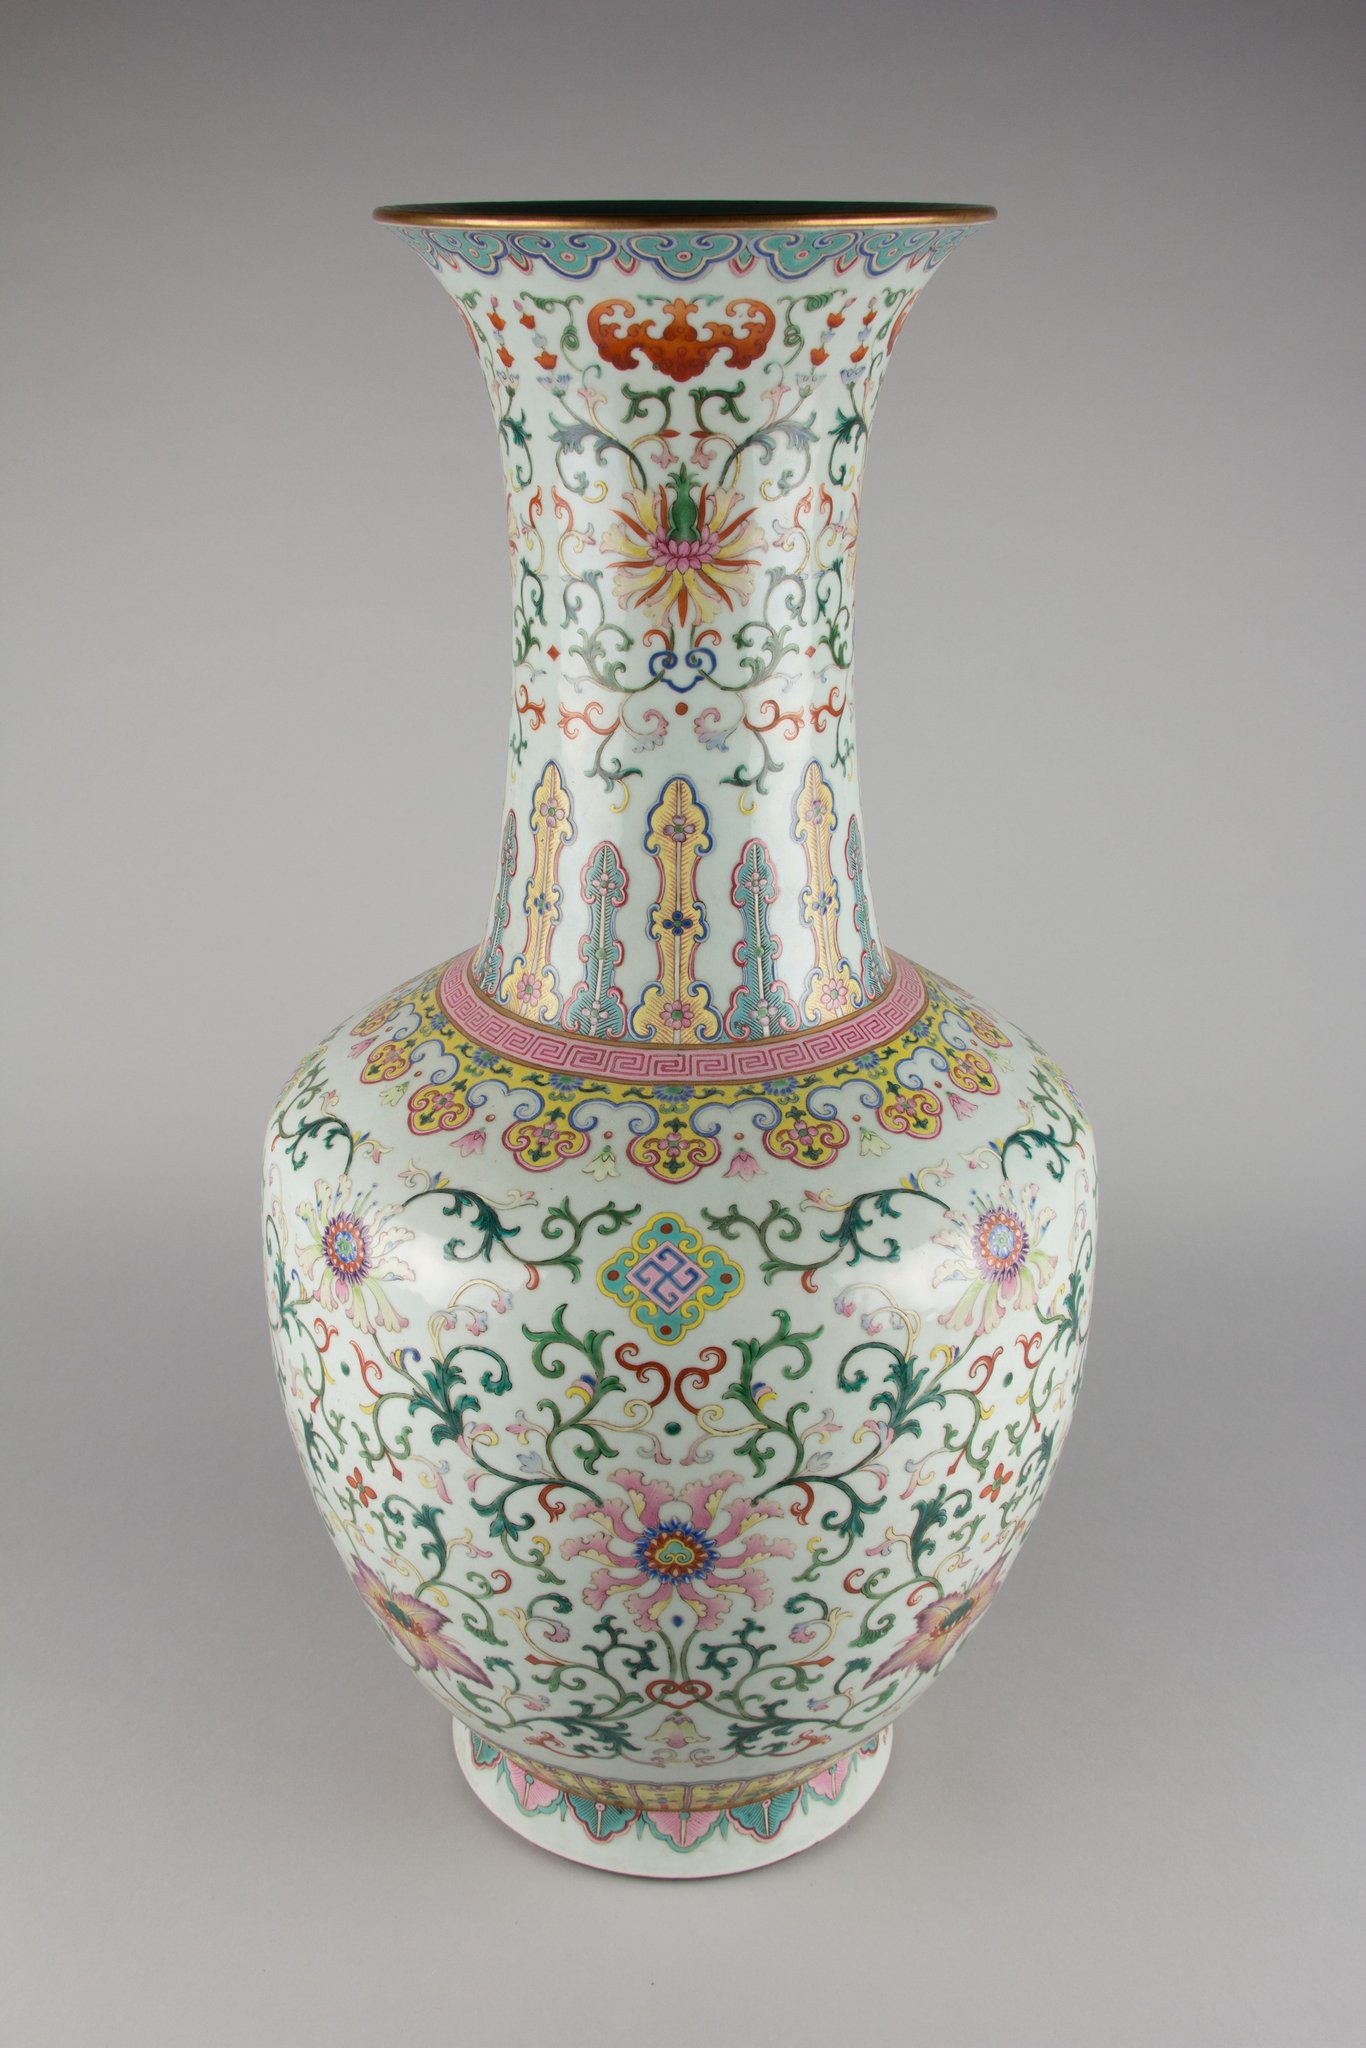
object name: vase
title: Vase with floral scrolls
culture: chinese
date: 1734-1766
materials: enamel, porcelain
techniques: overglaze, painting, polychrome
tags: flowers